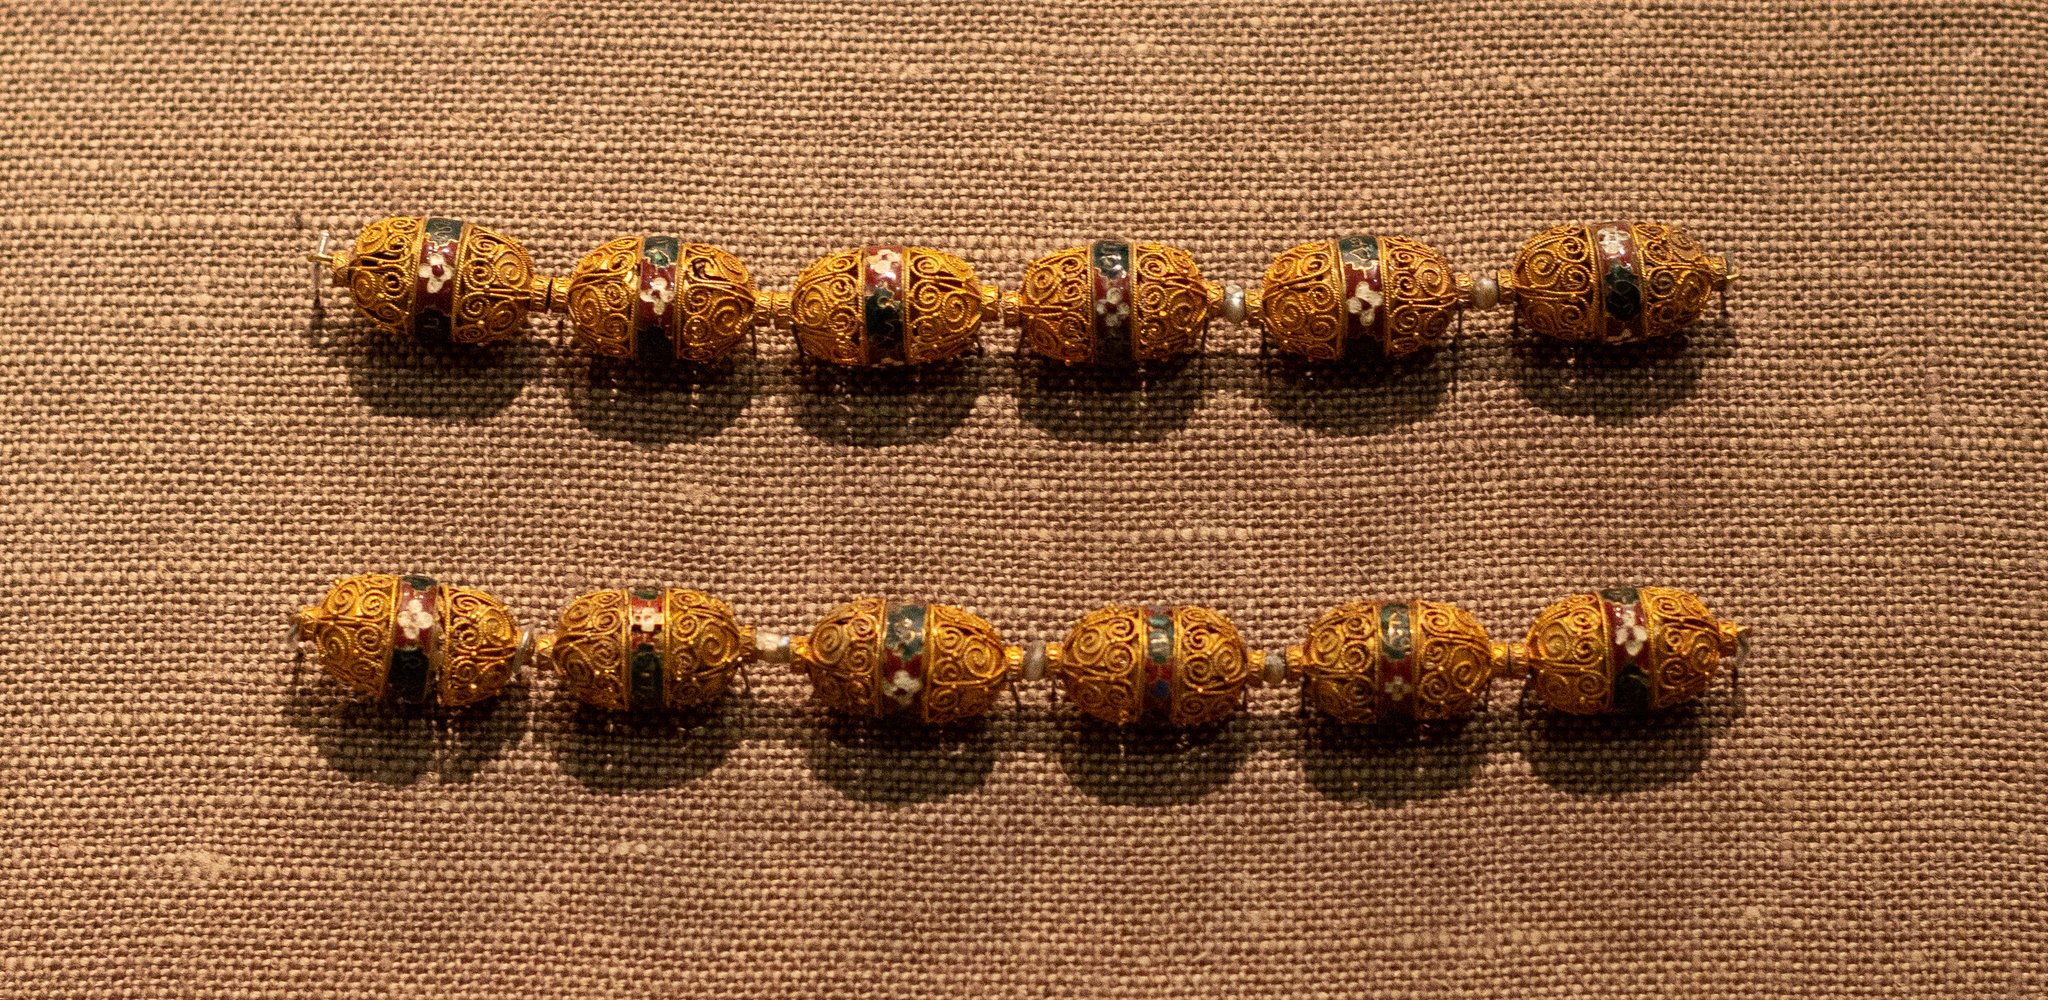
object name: bead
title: Beads from a Necklace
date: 1451-1500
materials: enamel, gold, pearl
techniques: enamel, filigree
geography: spain